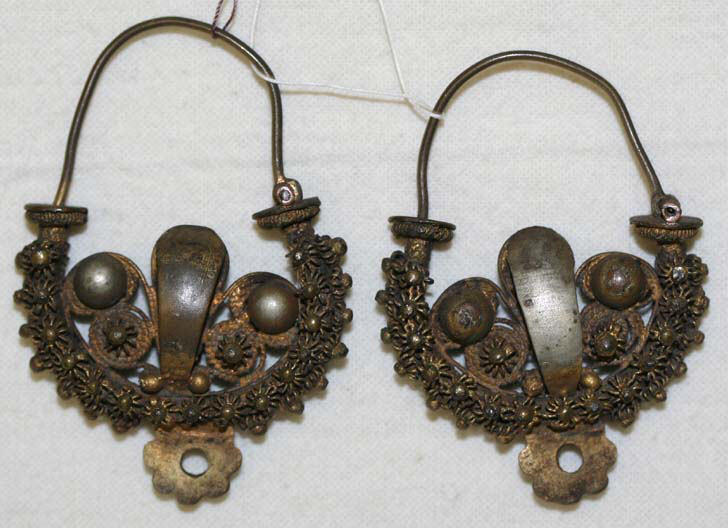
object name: earring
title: Earrings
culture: european, eastern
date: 1701-1900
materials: metal